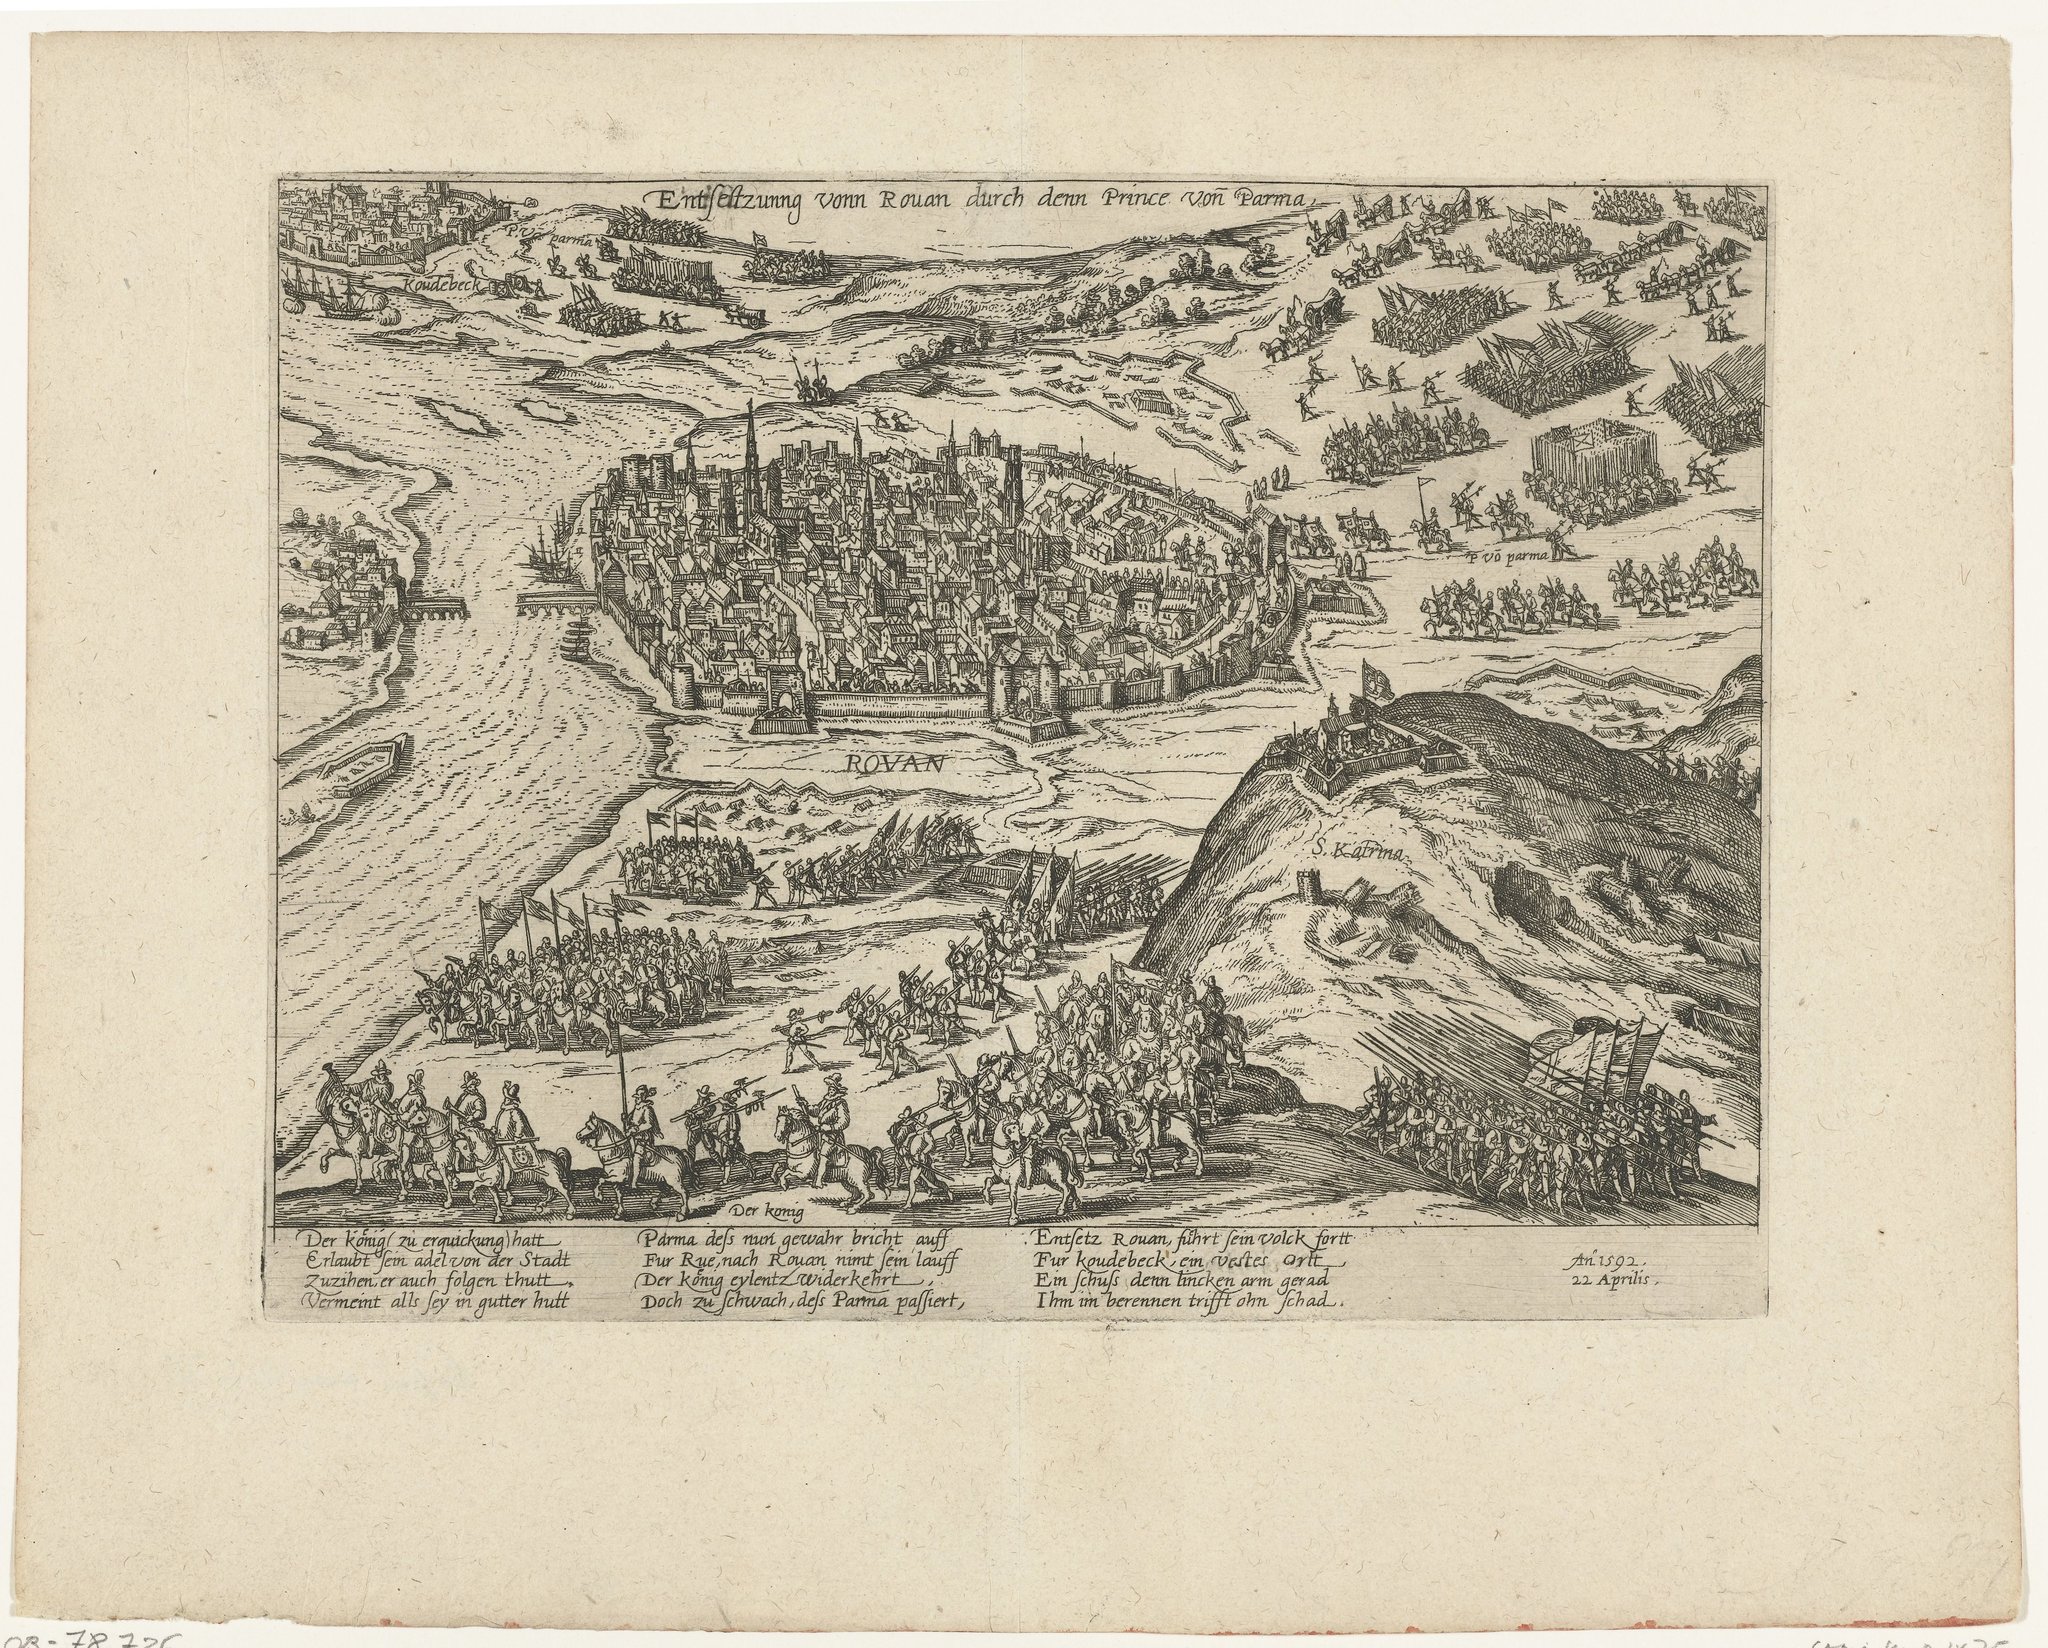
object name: print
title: Serie 4: Franse, Duitse en Engelse Gebeurtenissen, 1576-1610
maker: frans hogenberg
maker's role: print maker, publisher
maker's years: 1538-1590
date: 1592-1594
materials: paper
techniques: etching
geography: cologne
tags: rome, alessandro farnese (landvoogd van de nederlanden en hertog van parma en piacenza), paris, hendrik iv (koning van frankrijk en navarra), raising the siege with outside assistance, relief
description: Rouen door de hertog van Parma ontzet en van proviand voorzien, 22 april 1592. Rechts boven trekken de troepen van de hertog van Parma op naar de stad, op de voorgrond heffen de troepen van de koning hun beleg op en vertrekken. Met onderschrift van 12 regels in het Duits. Ongenummerd. Papier met rode randjes. Kopie of herhaling naar de prent van Hogenberg.